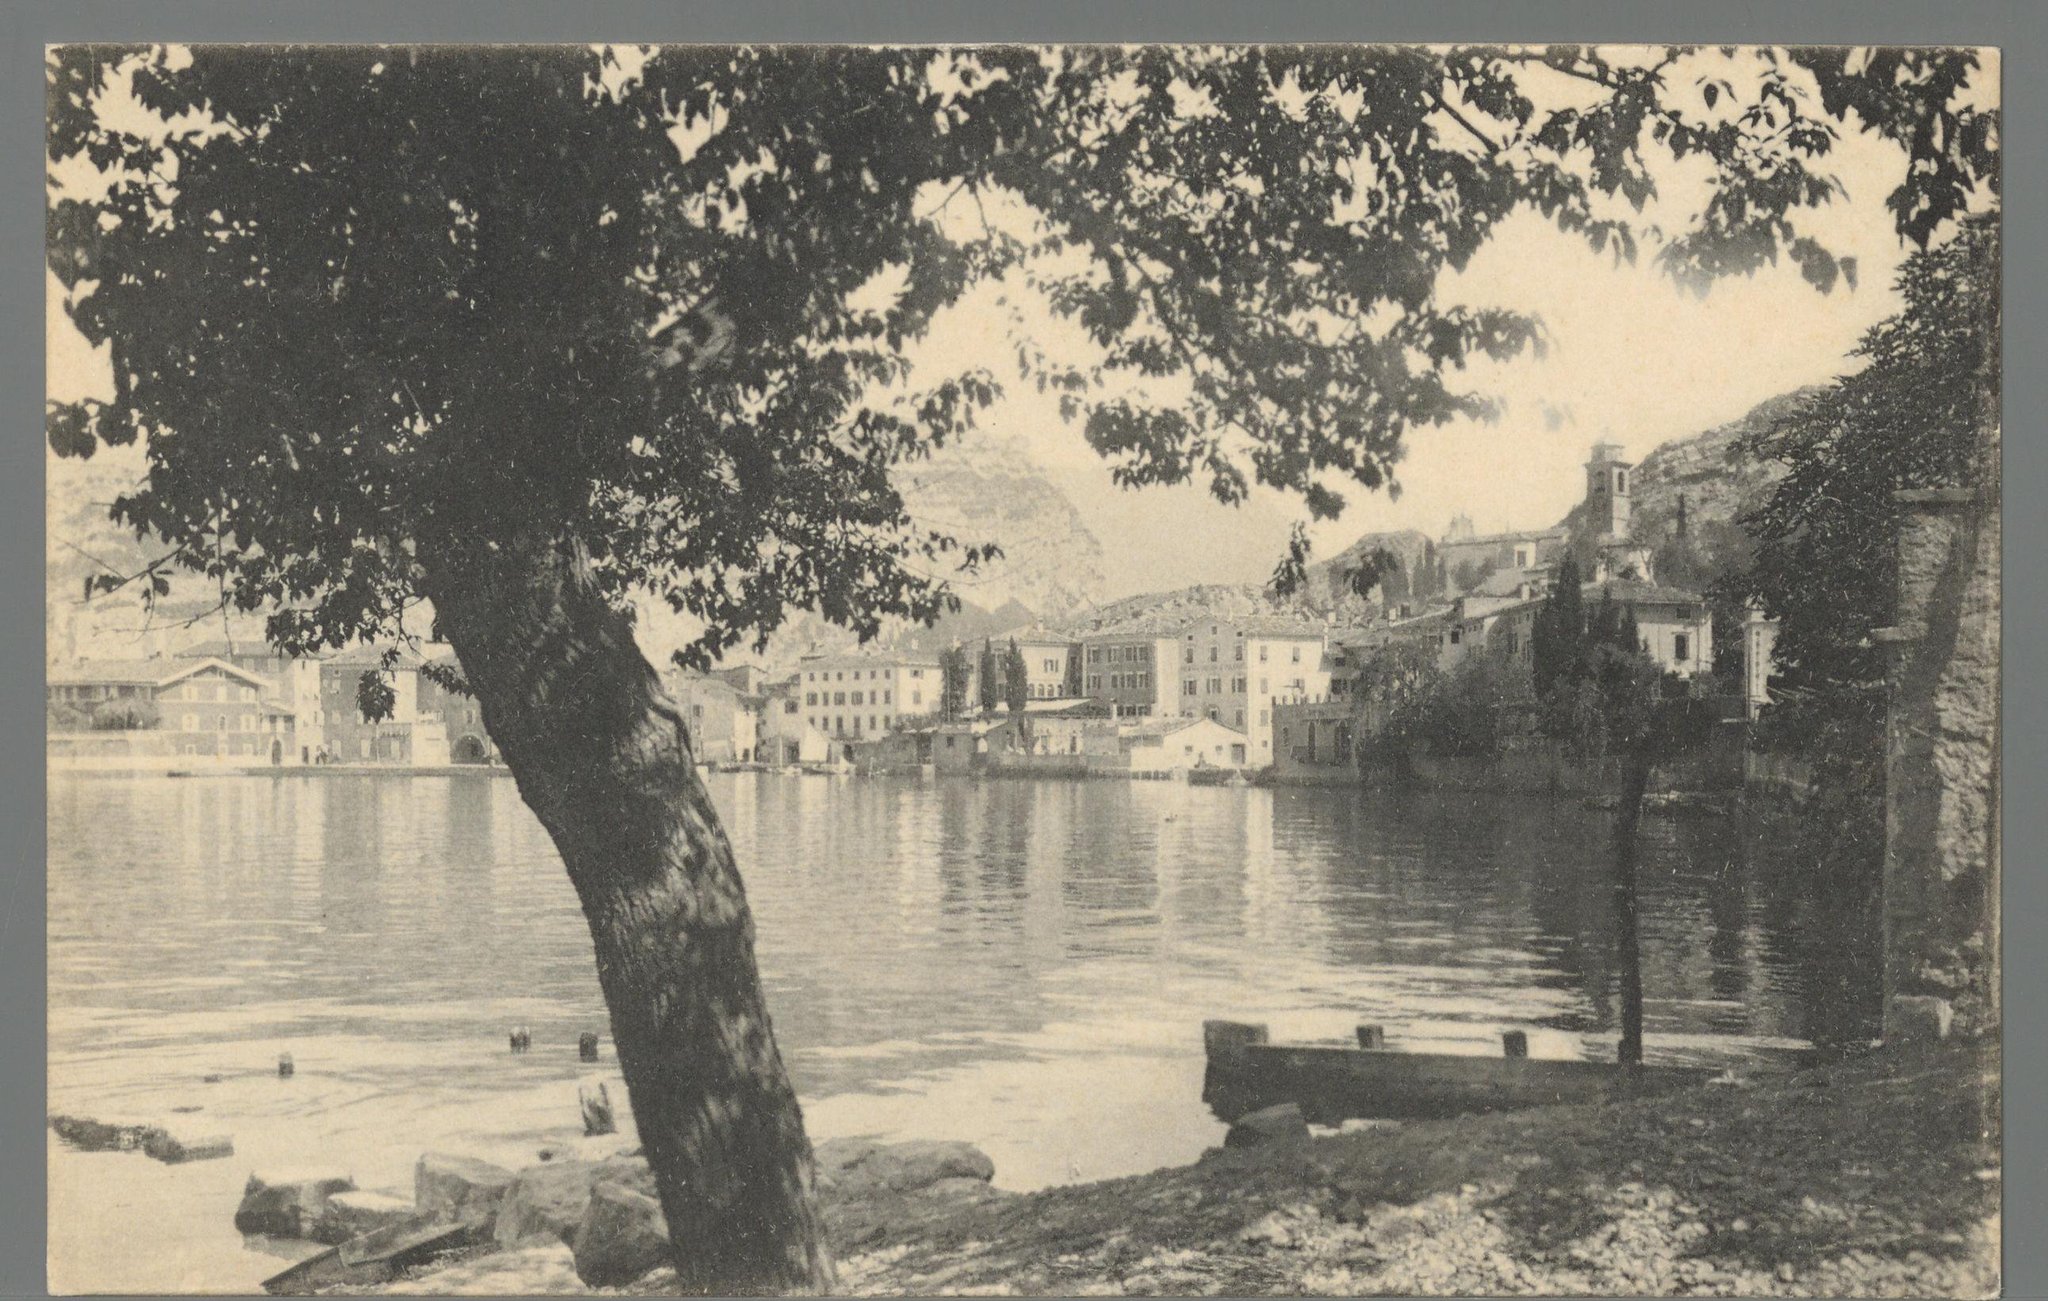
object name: photomechanical print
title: Gardasee. Torbole. Stimmungsbild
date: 1905-1920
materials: cardboard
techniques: photograph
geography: riva del garda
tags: prospect of village, silhouette of village, trees, lake